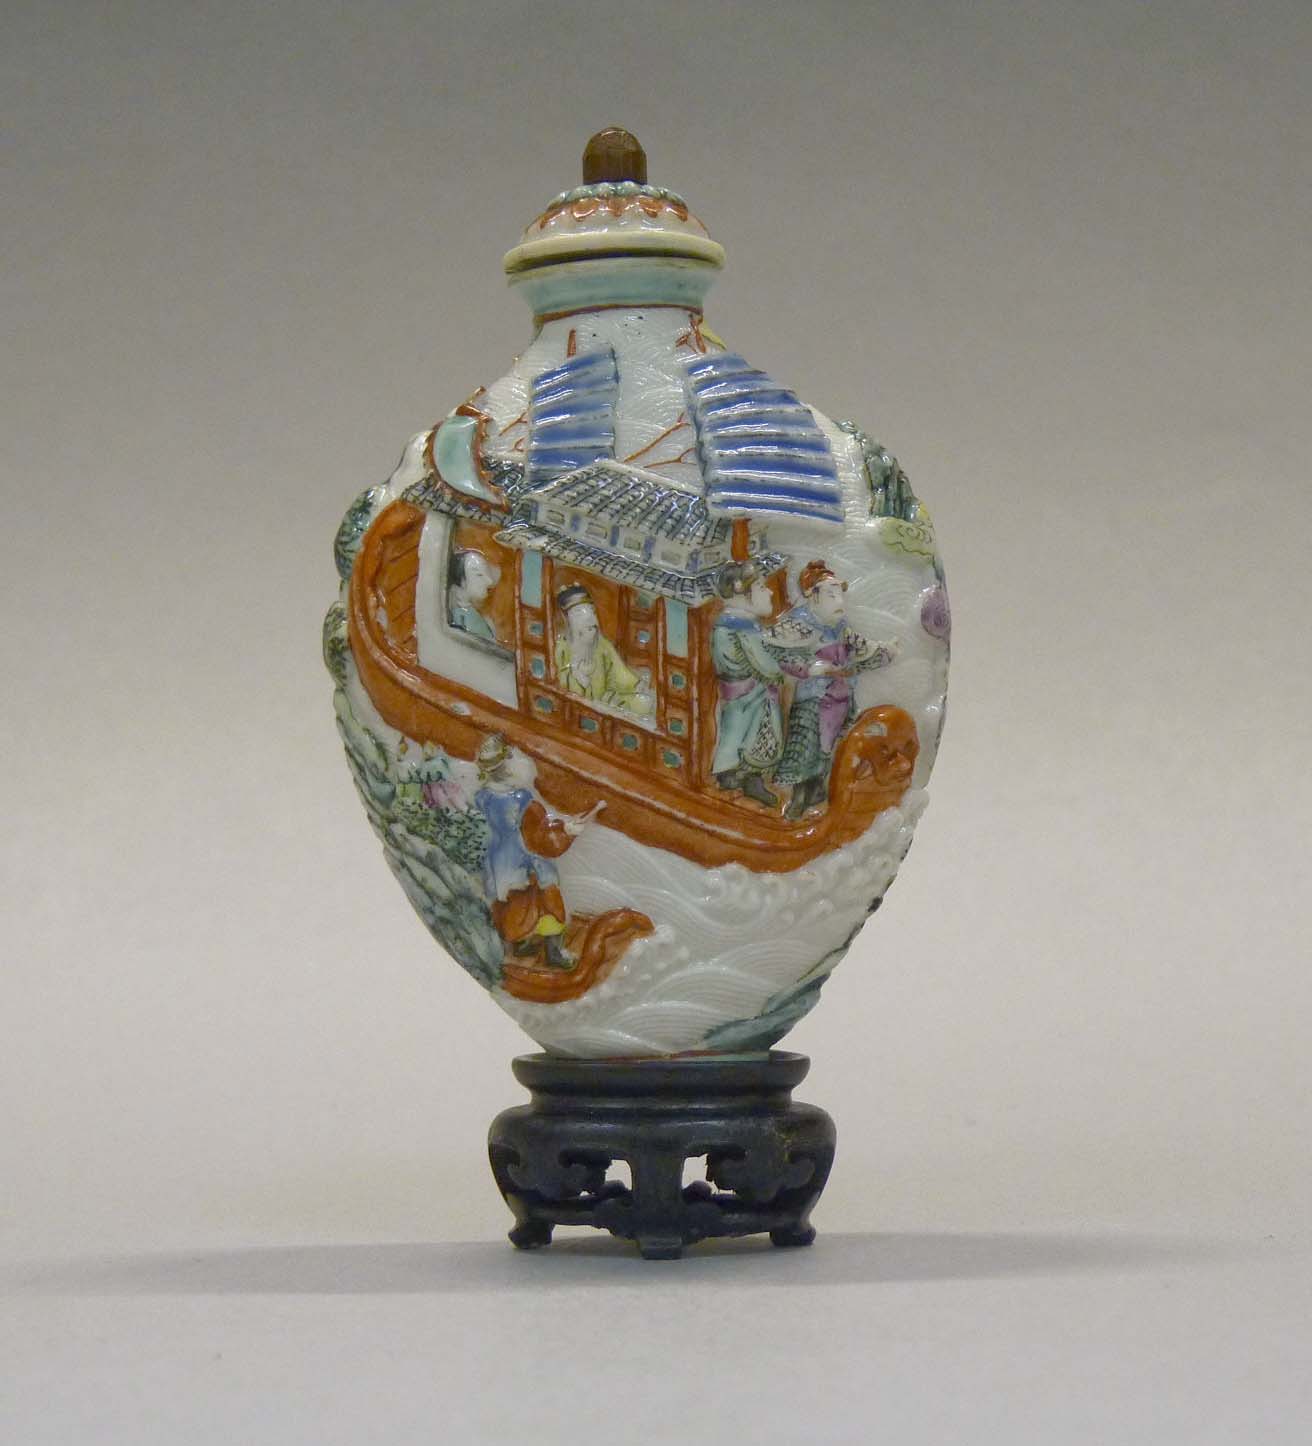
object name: snuff bottle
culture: chinese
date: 1736-1795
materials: porcelain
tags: human figures,boats